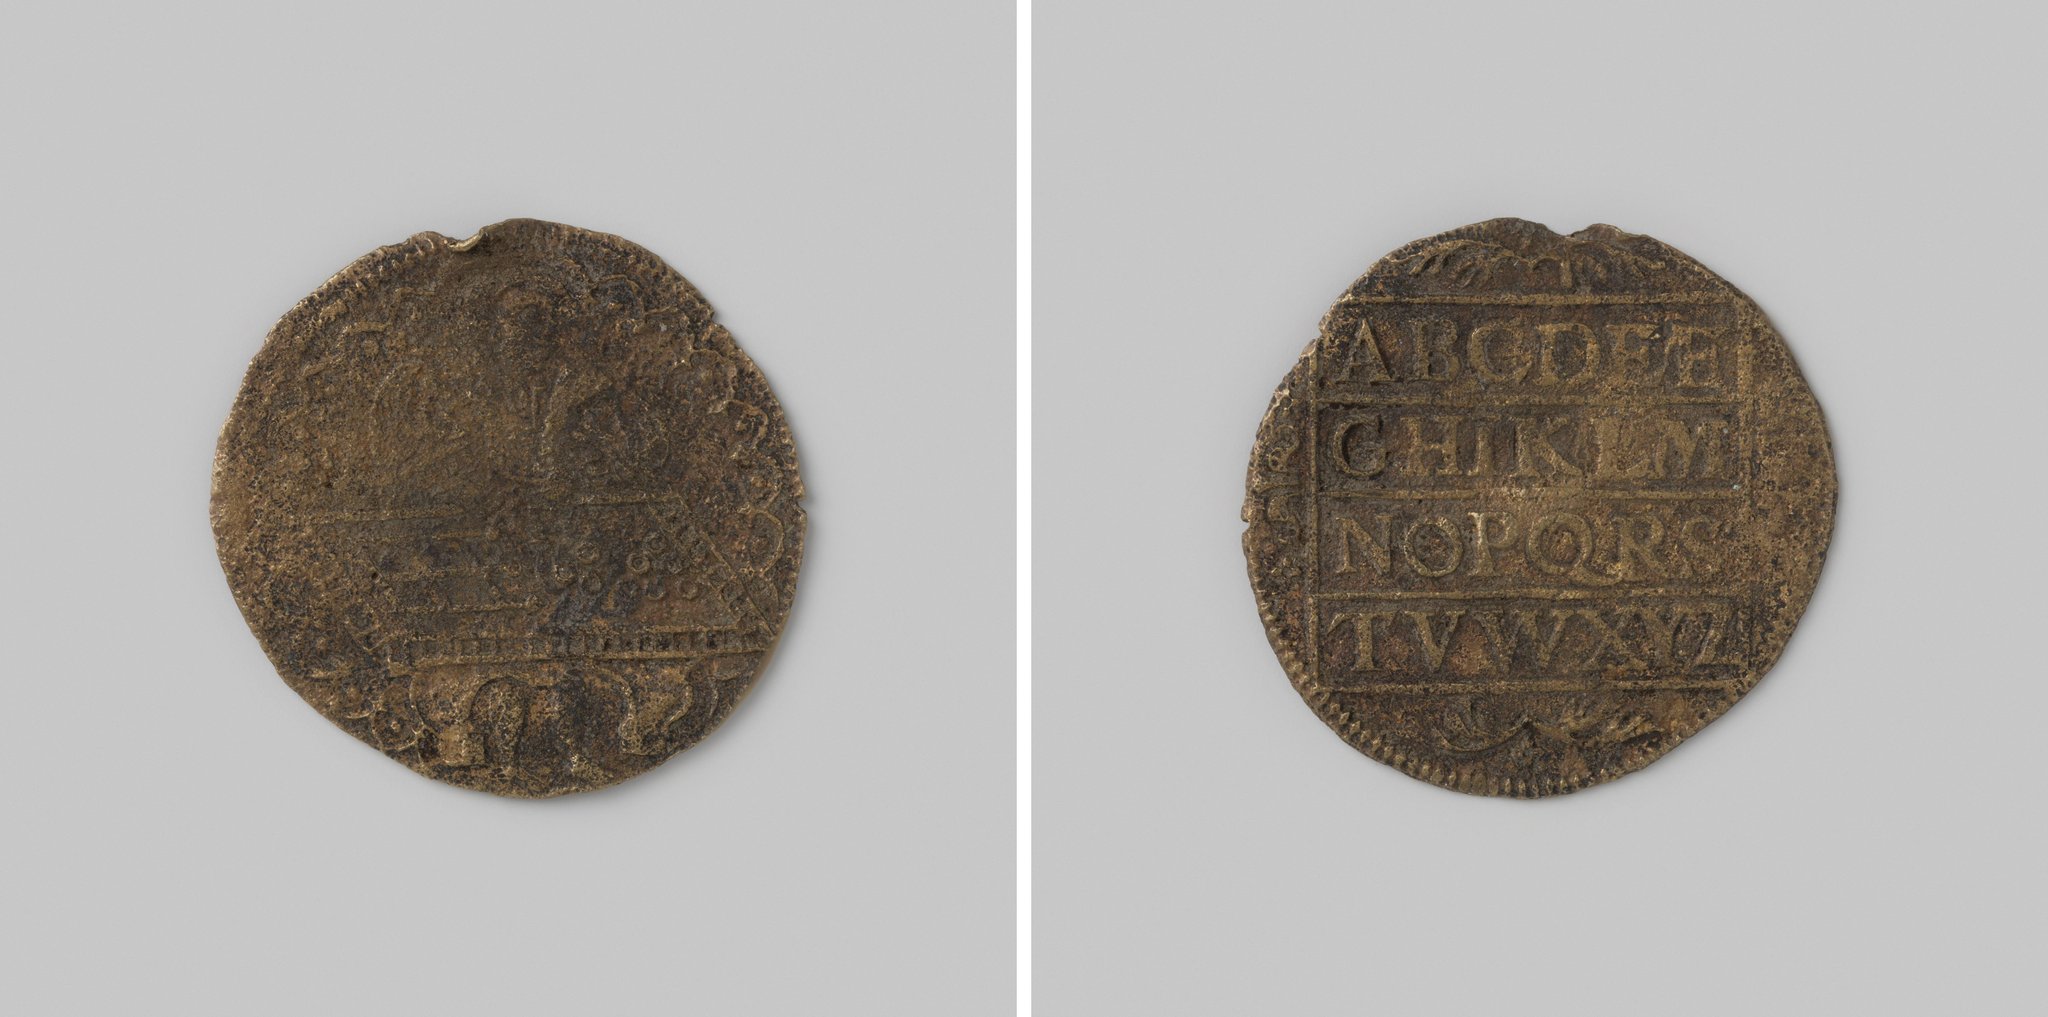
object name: history medal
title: Rekenpenning uit Neurenberg van het Rechenmeister-type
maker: Anonymous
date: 1550-1650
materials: brass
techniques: striking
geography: nuremberg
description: Messing penning, op de voorzijde een man achter een rekentafel binnen een veelpas, op de keerzijde een versierd vierkant met het alfabet in vier regels.